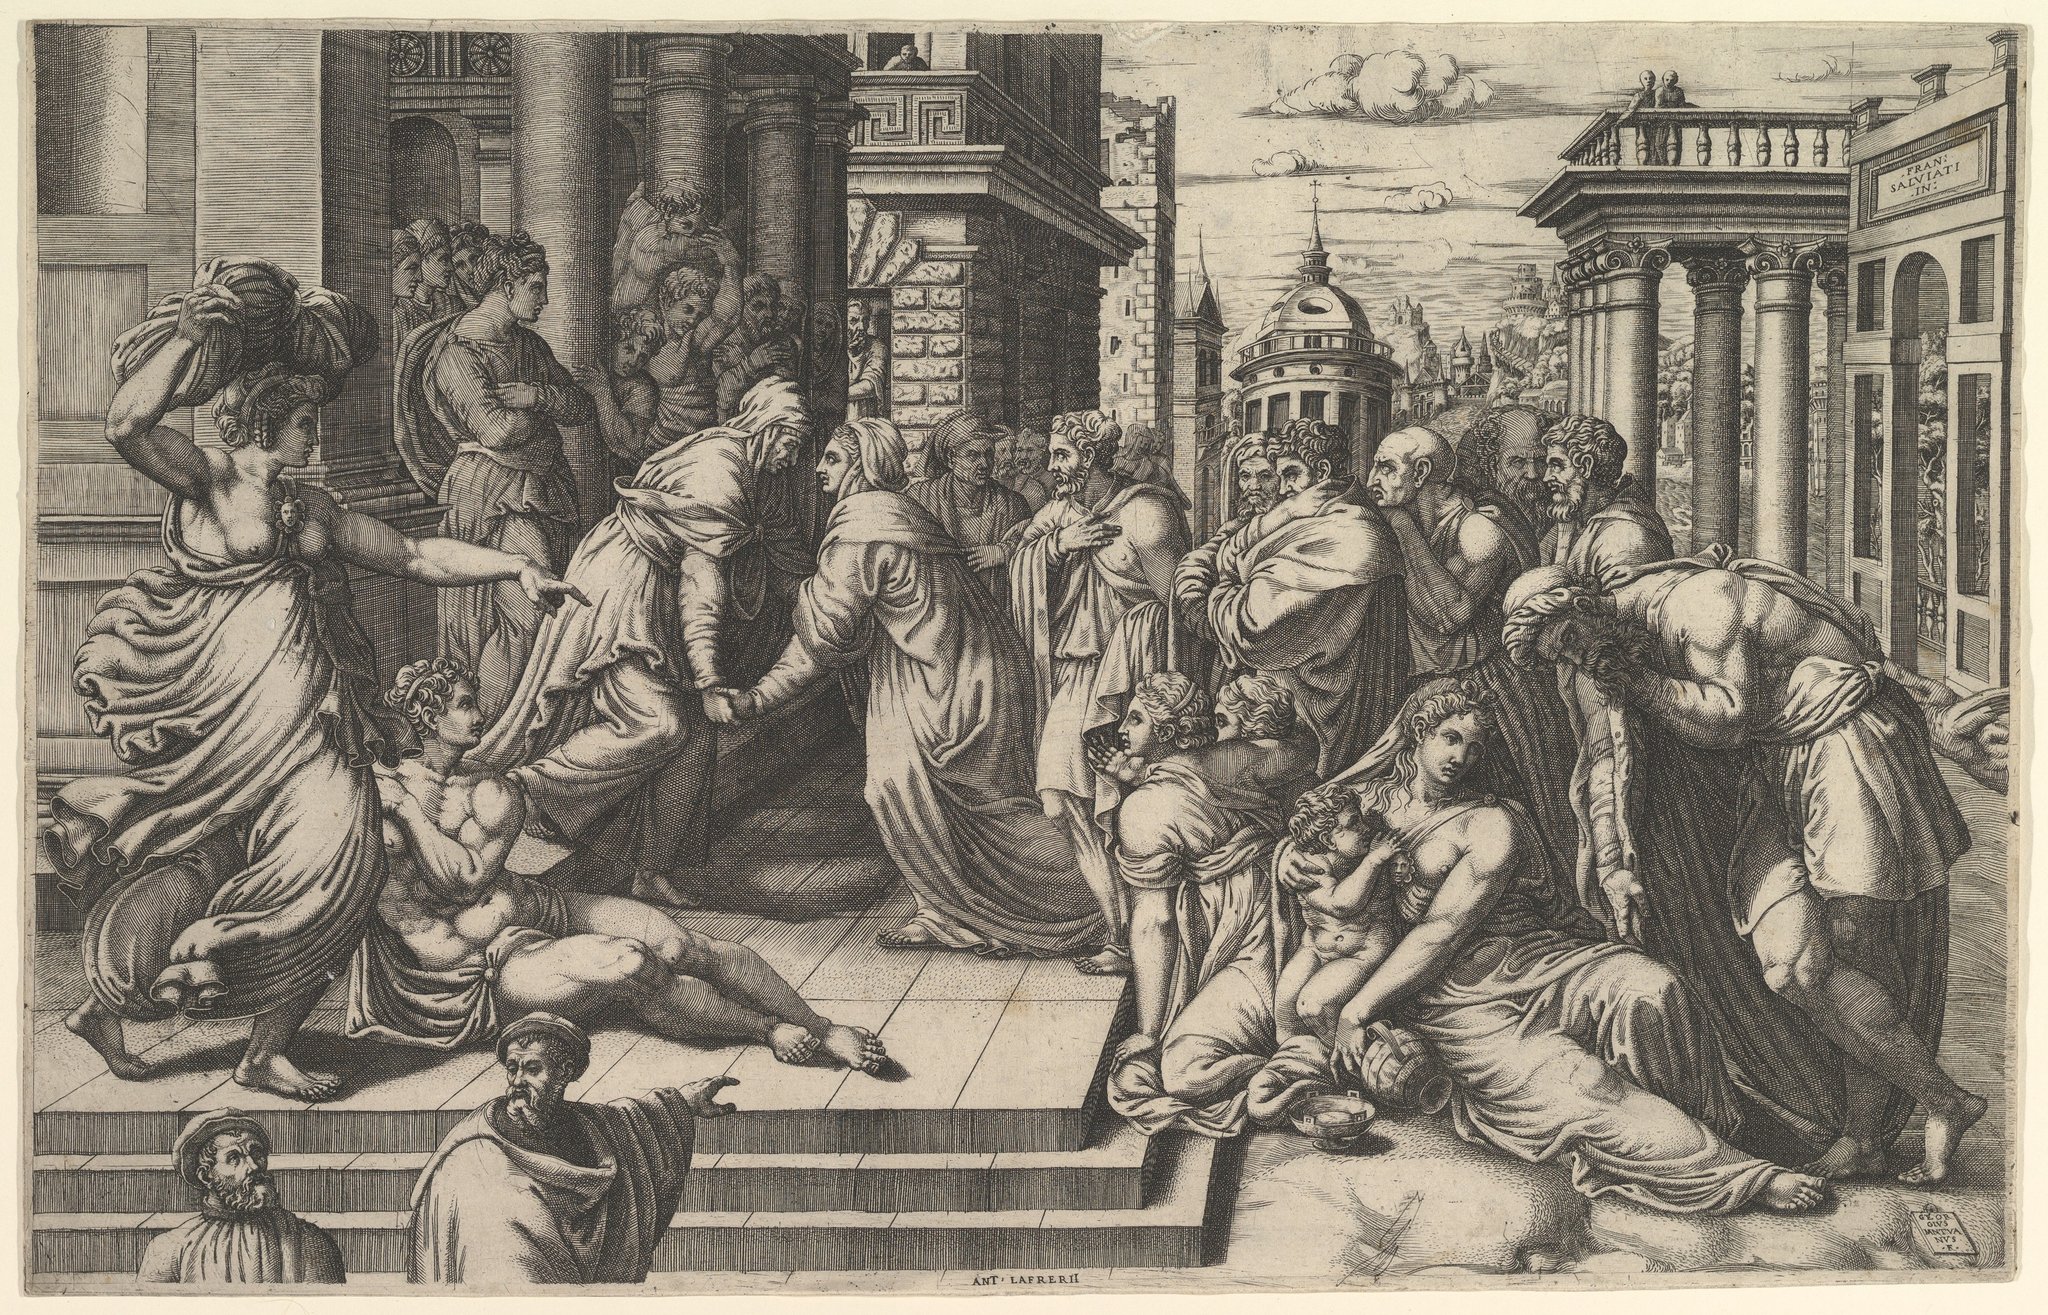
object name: print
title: The Visitation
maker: giorgio ghisi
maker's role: artist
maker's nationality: italian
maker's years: 1515-1582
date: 1540-1550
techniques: engraving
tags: men,women